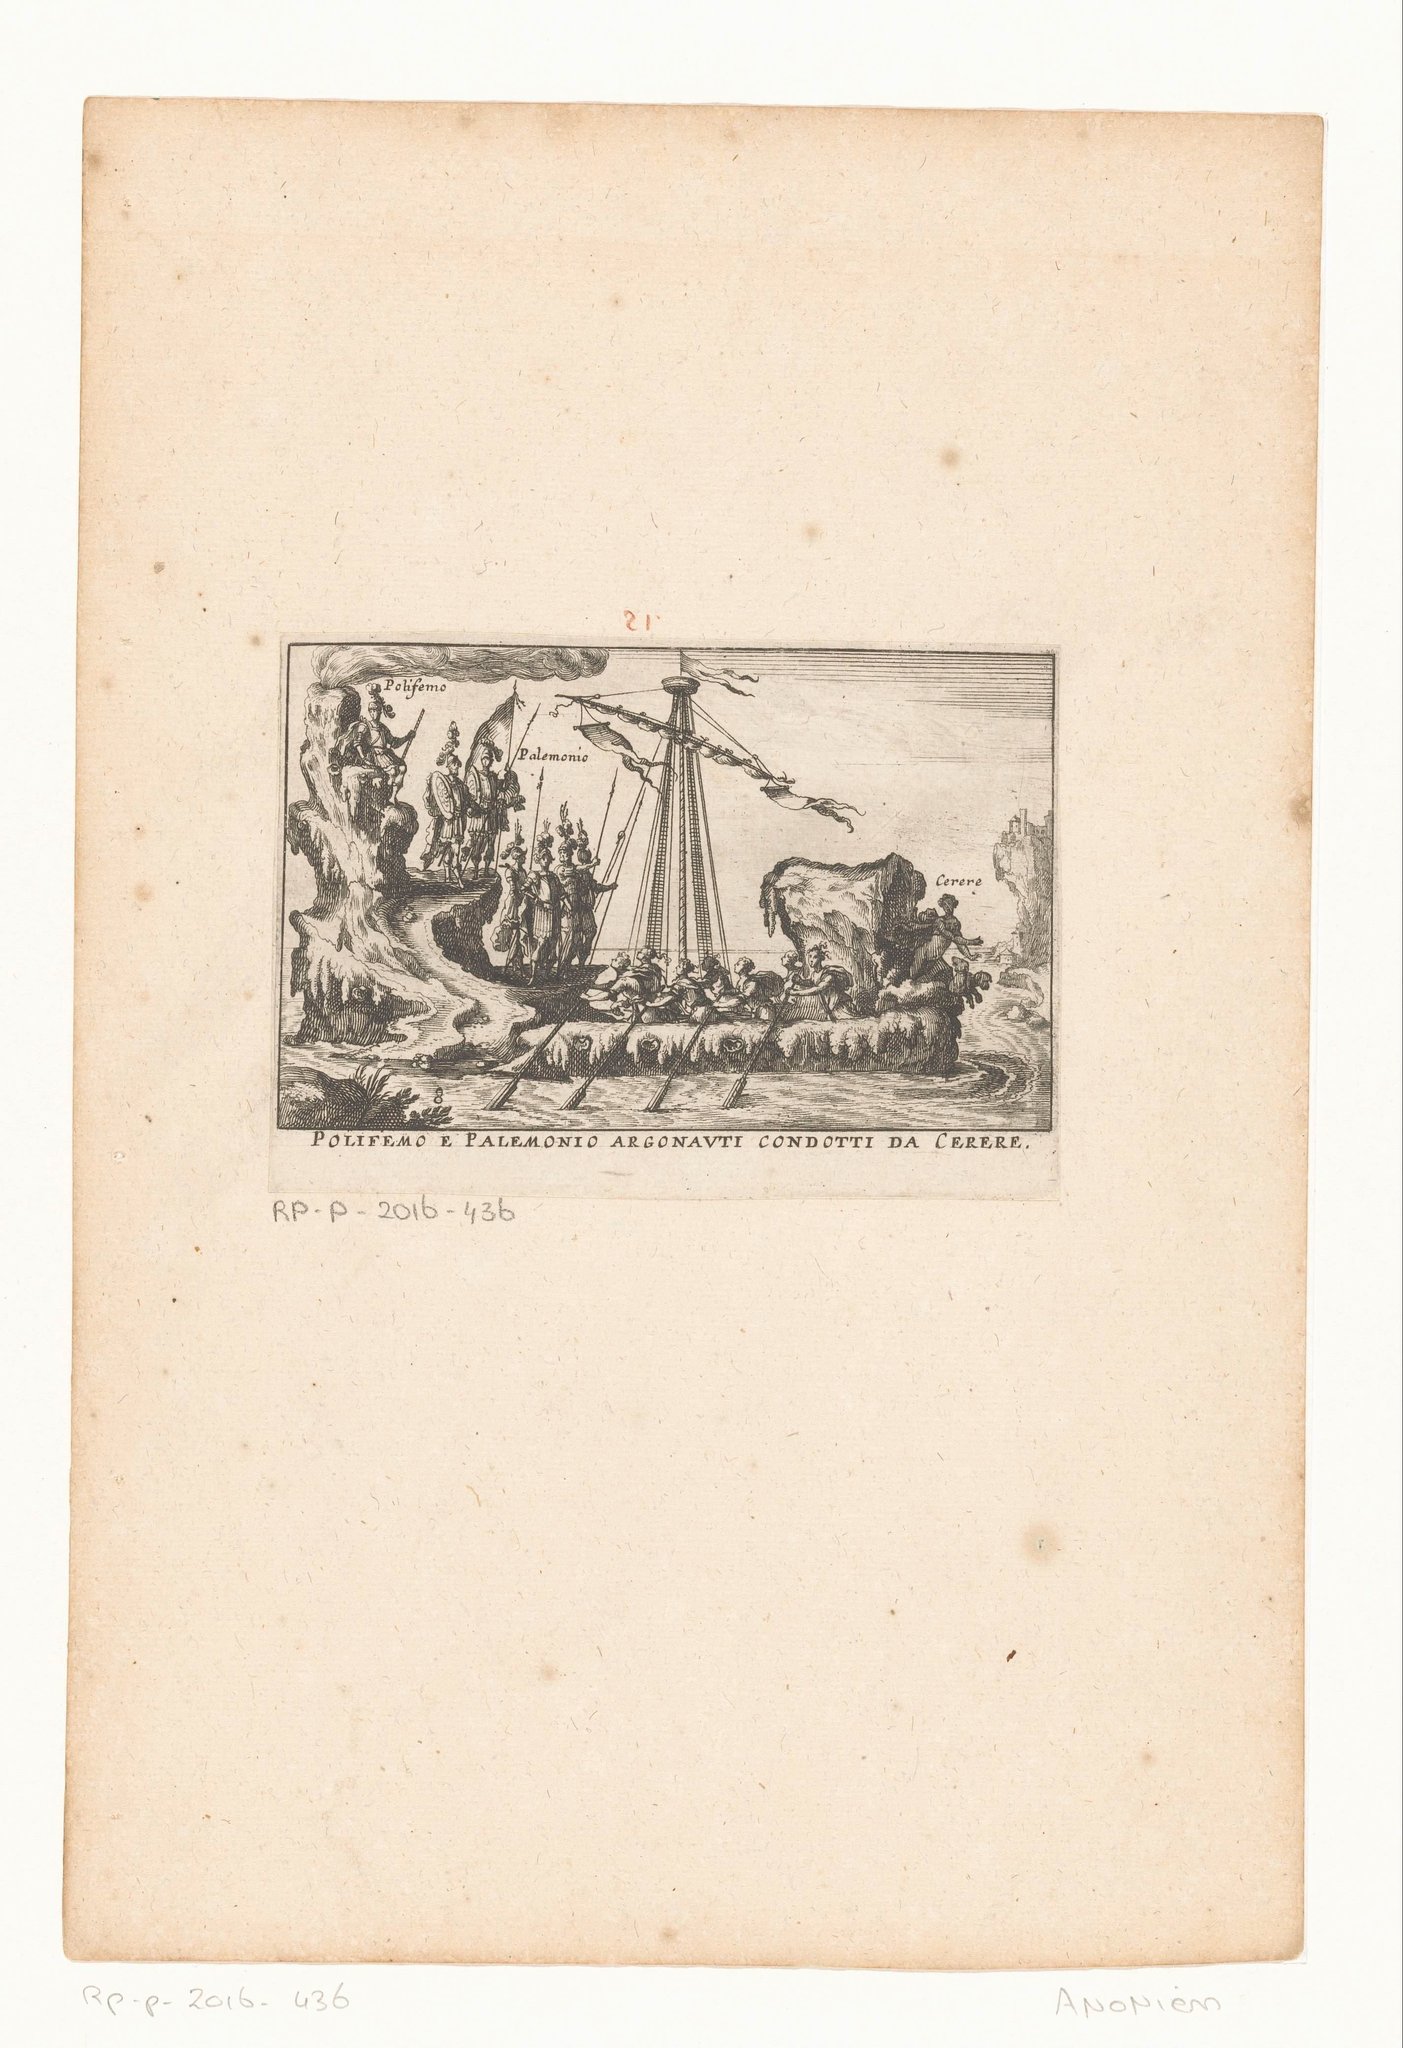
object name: print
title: Letter E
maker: Anonymous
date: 1700-1799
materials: paper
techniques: etching, letterpress printing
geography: netherlands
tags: fancy letters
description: Letter E tegen een achtergrond met vlechtwerk, rookvaten, guirlandes en maskers.